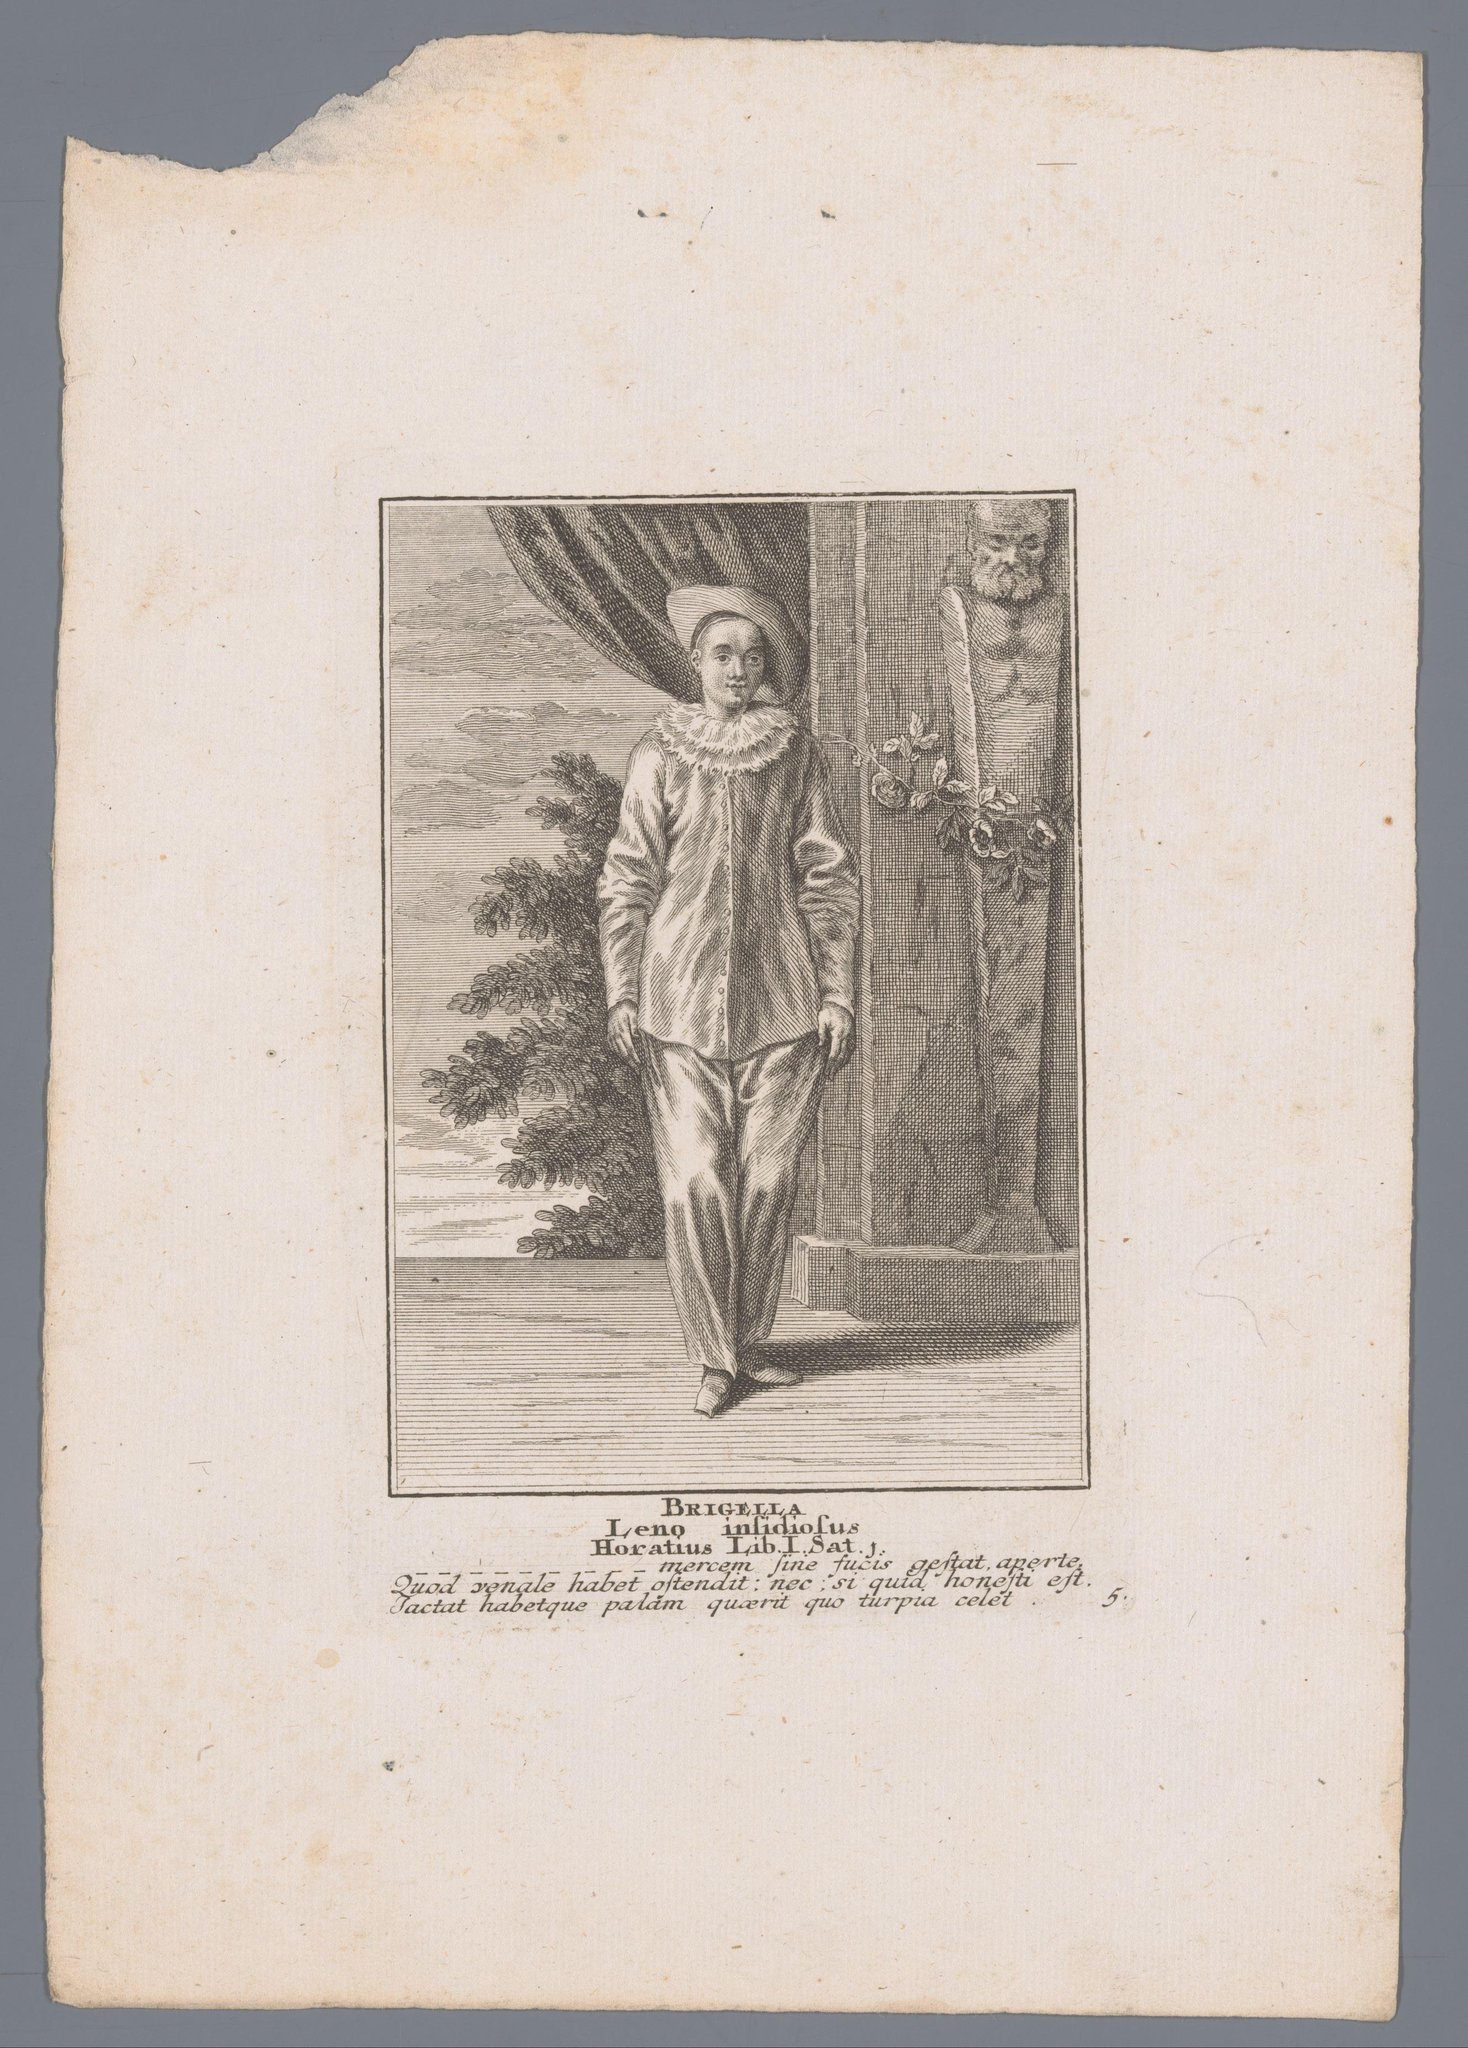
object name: print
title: Brigella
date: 1694-1725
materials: paper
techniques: etching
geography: nuremberg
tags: types in 'commedia dell'arte', group of actors, troupe; actors on the stage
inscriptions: collector's mark: Lugt 2228